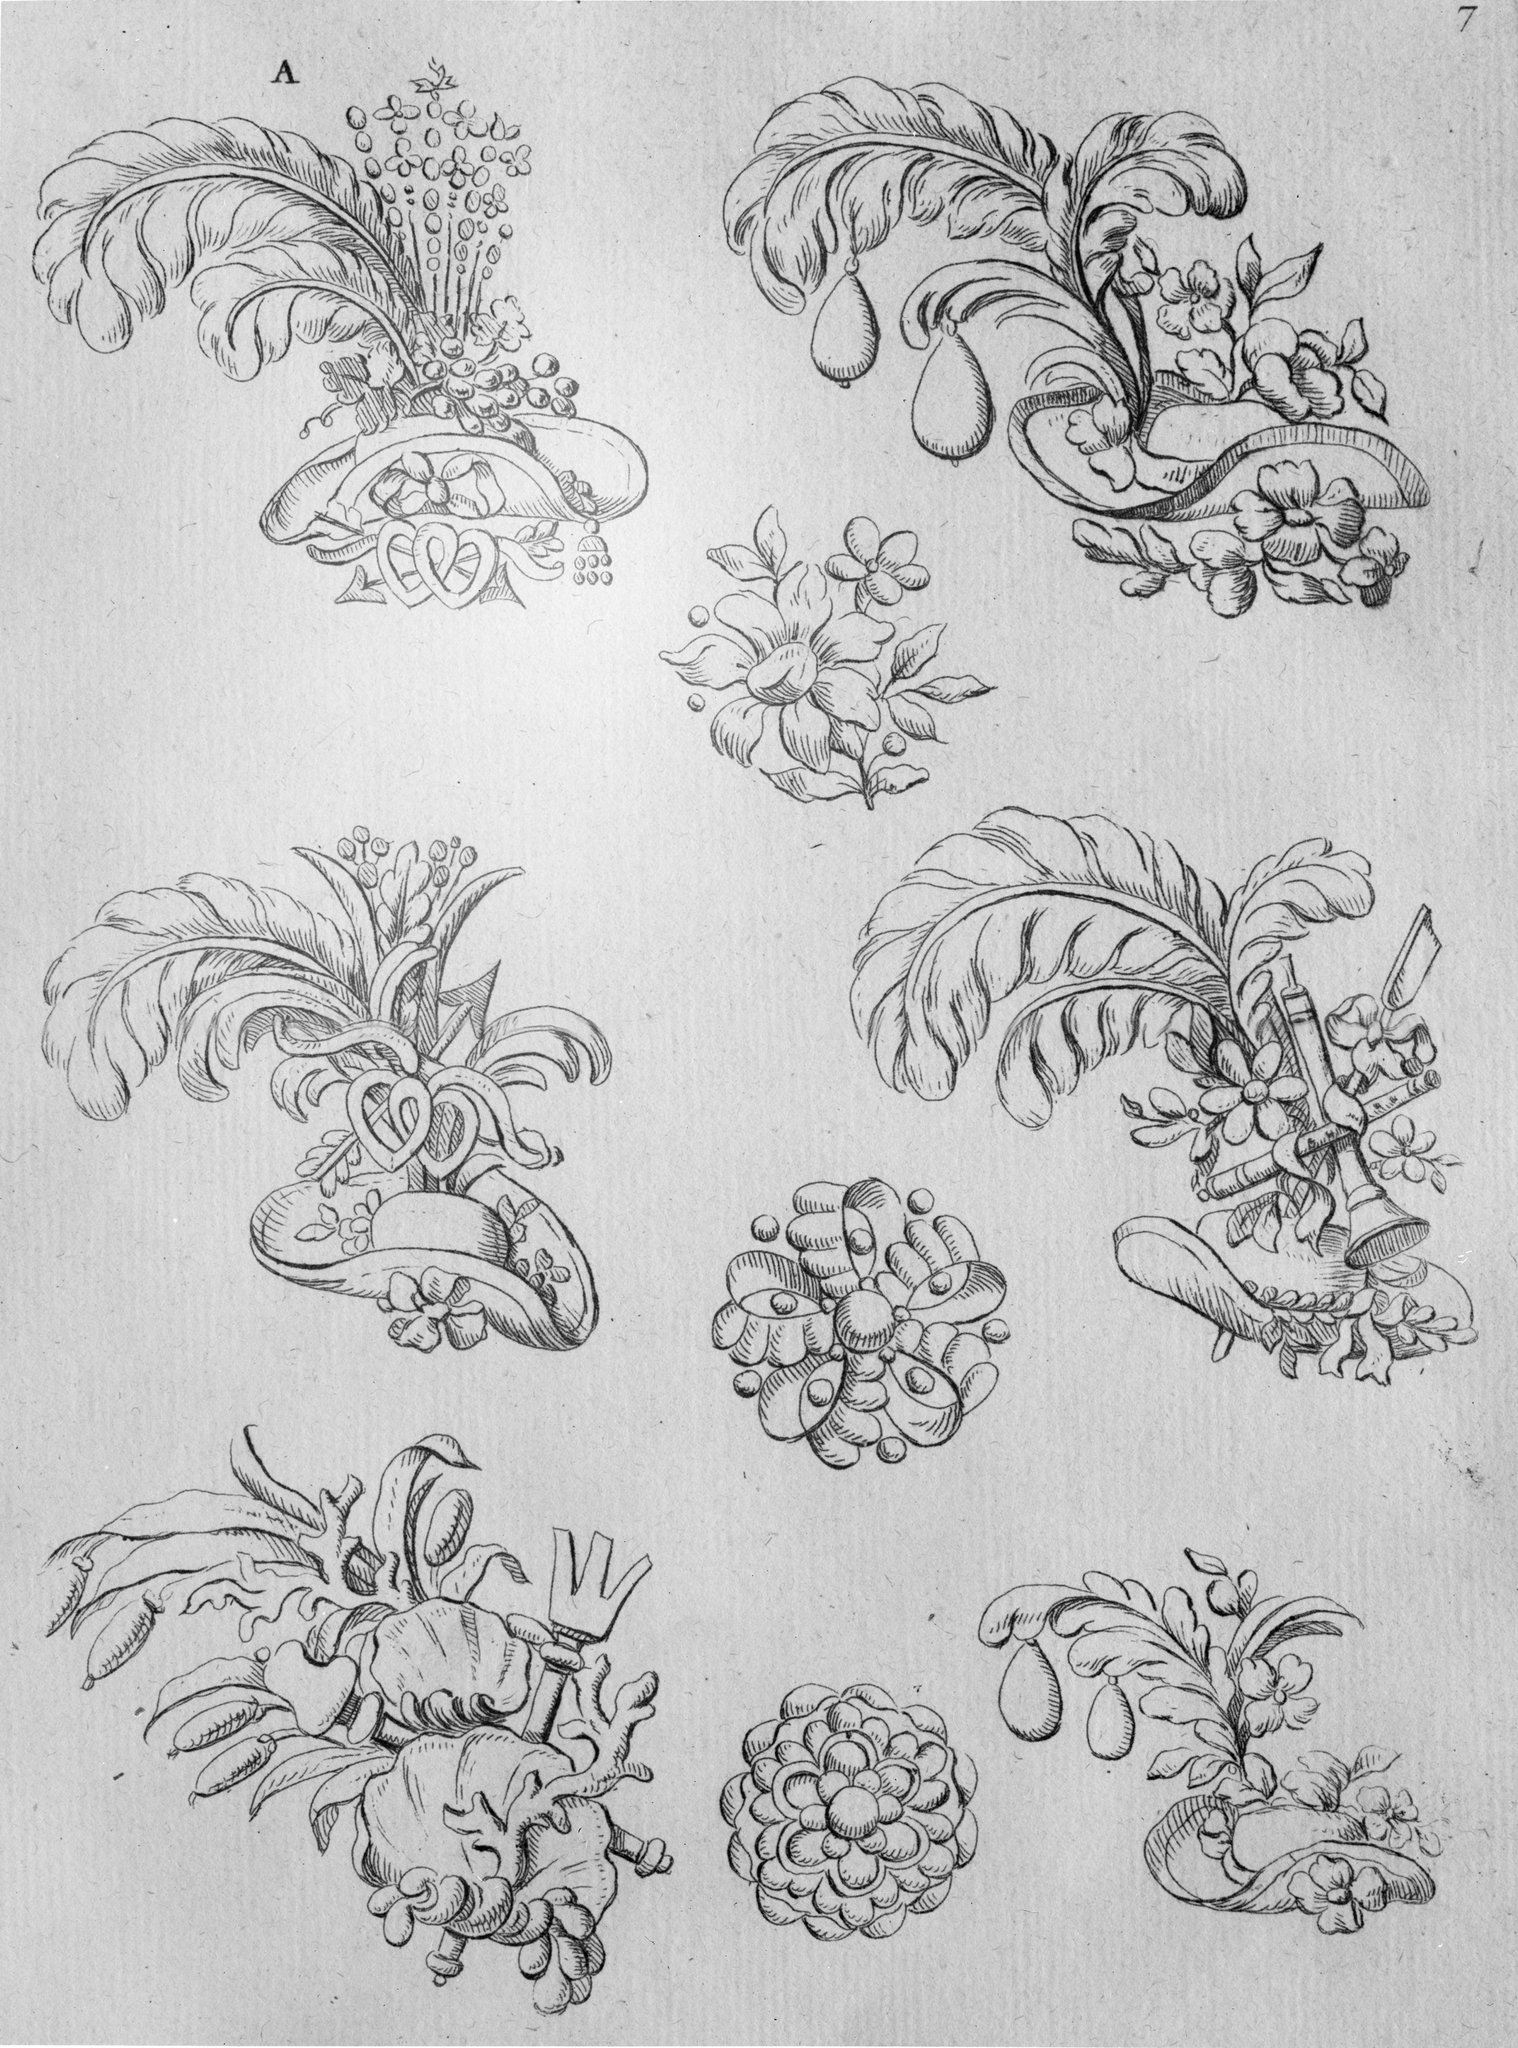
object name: book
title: Traité des Pierres Précieuses et de la maniere de les employer en Parure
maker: pouget fils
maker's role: publisher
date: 1762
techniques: engraving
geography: france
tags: hats,flutes,flowers,leaves